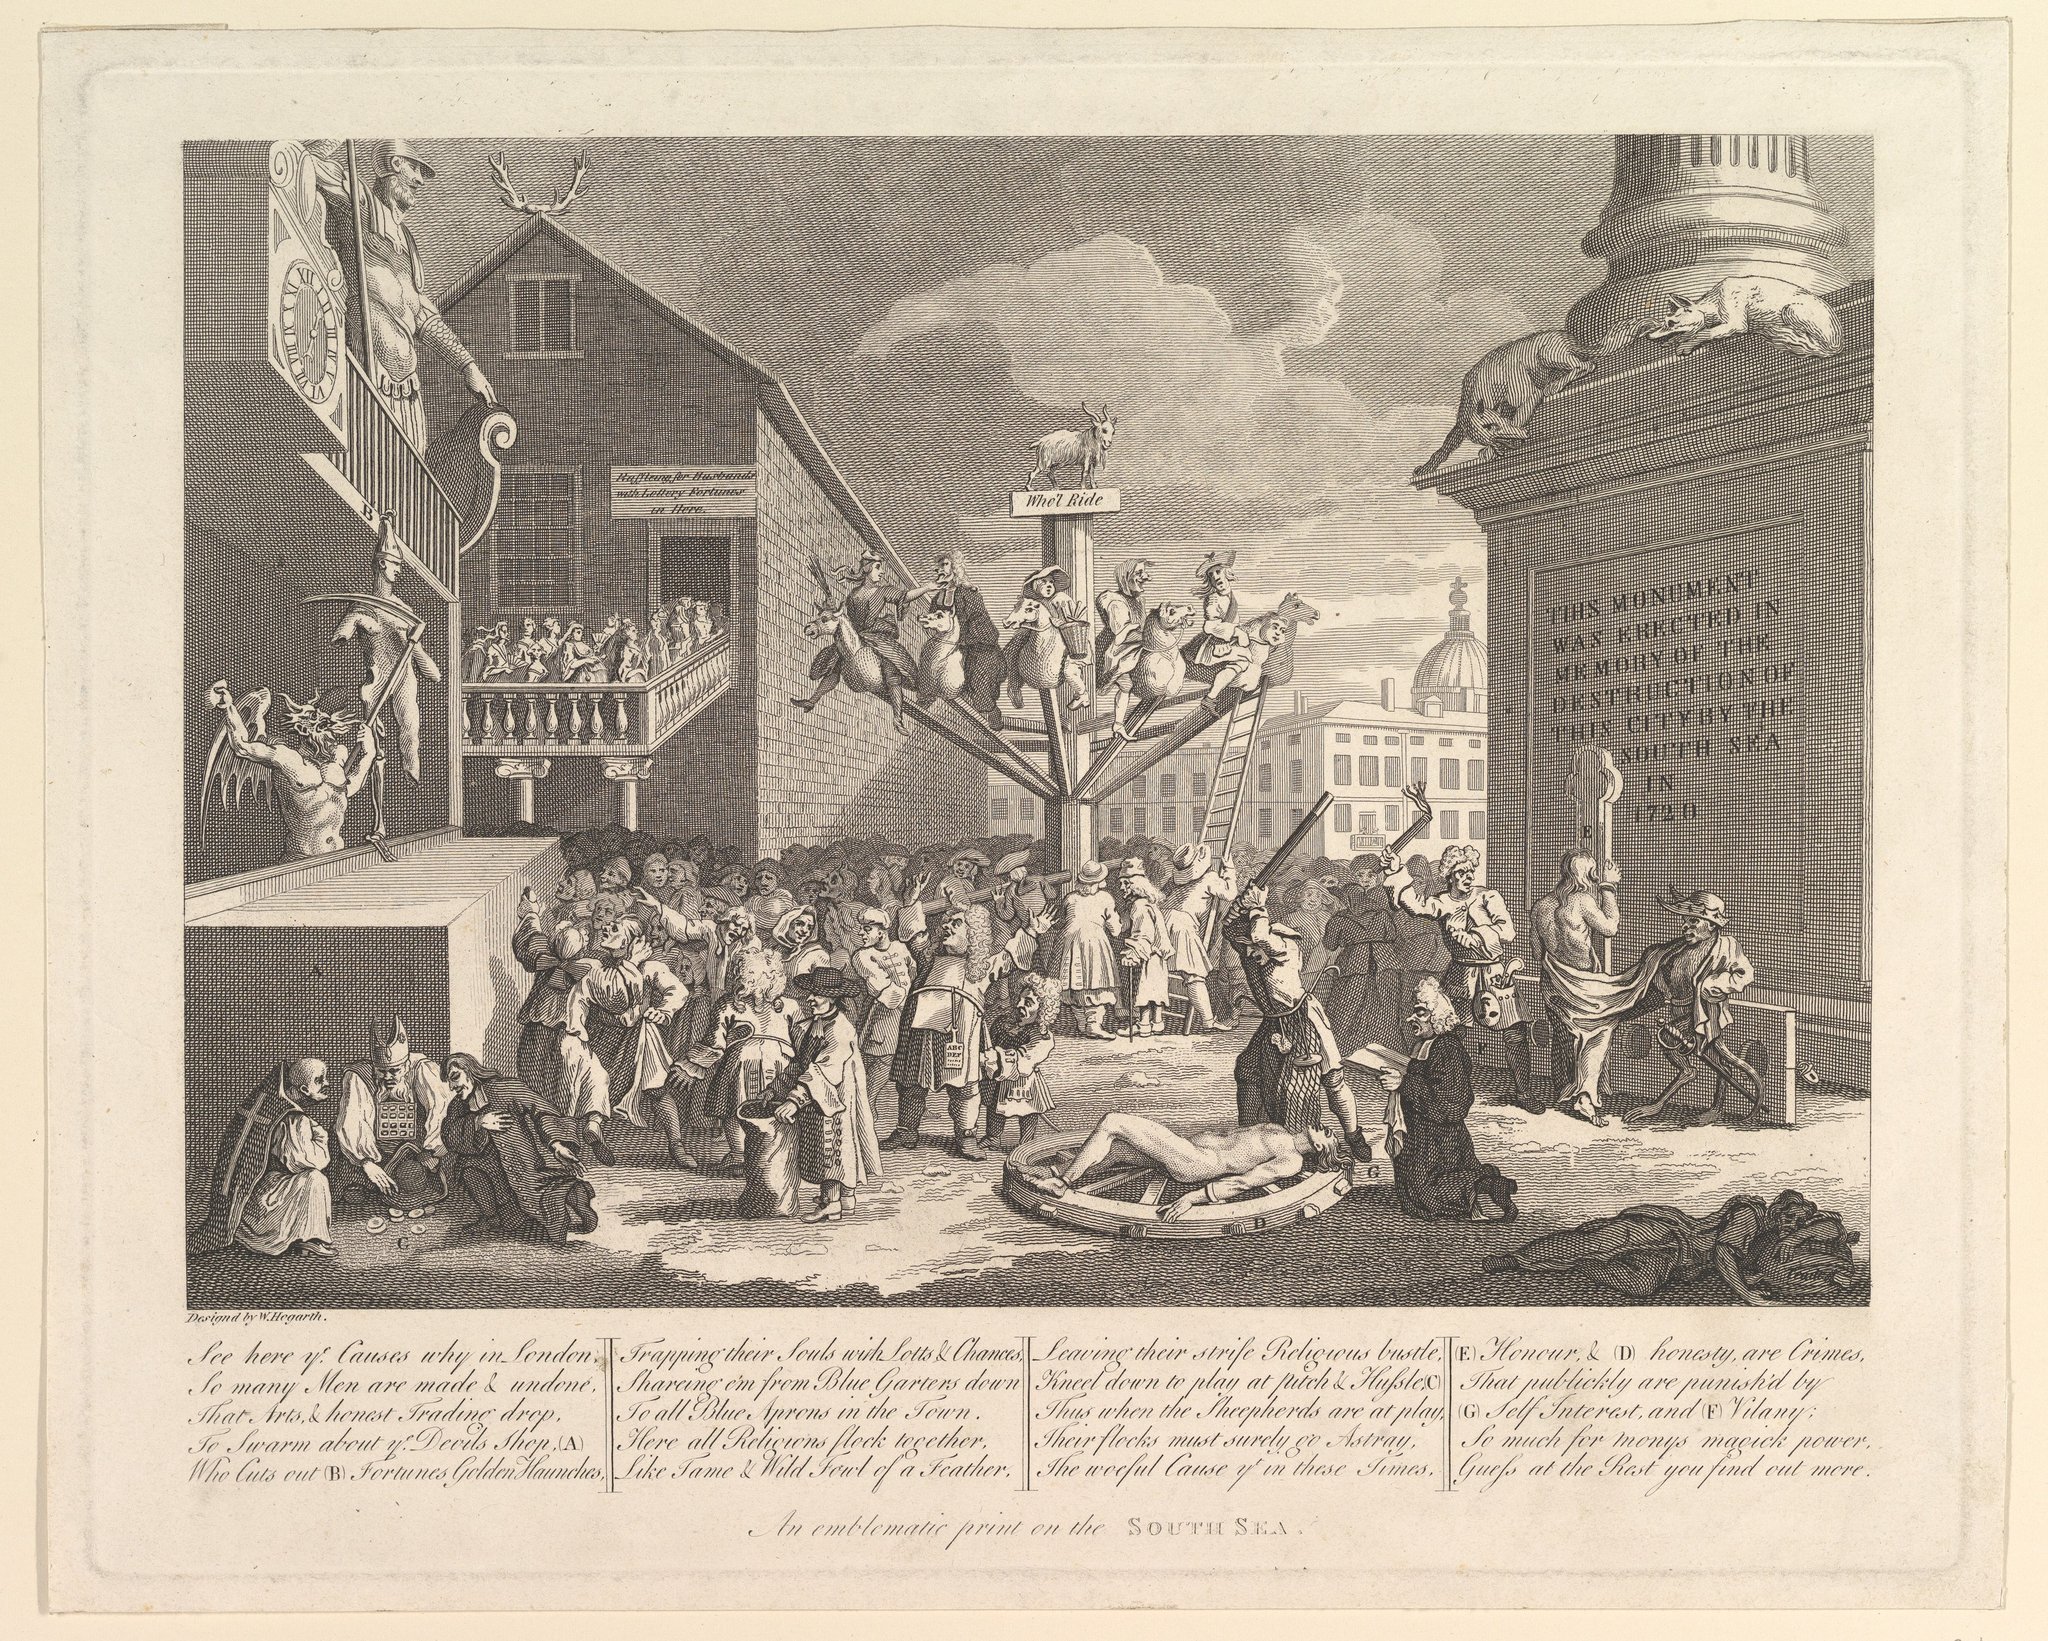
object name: print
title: An Emblematic Print on the South Sea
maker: william hogarth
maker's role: artist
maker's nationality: british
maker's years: 1697-1764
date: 1767-1800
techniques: engraving, etching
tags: suffering,goats,crowd